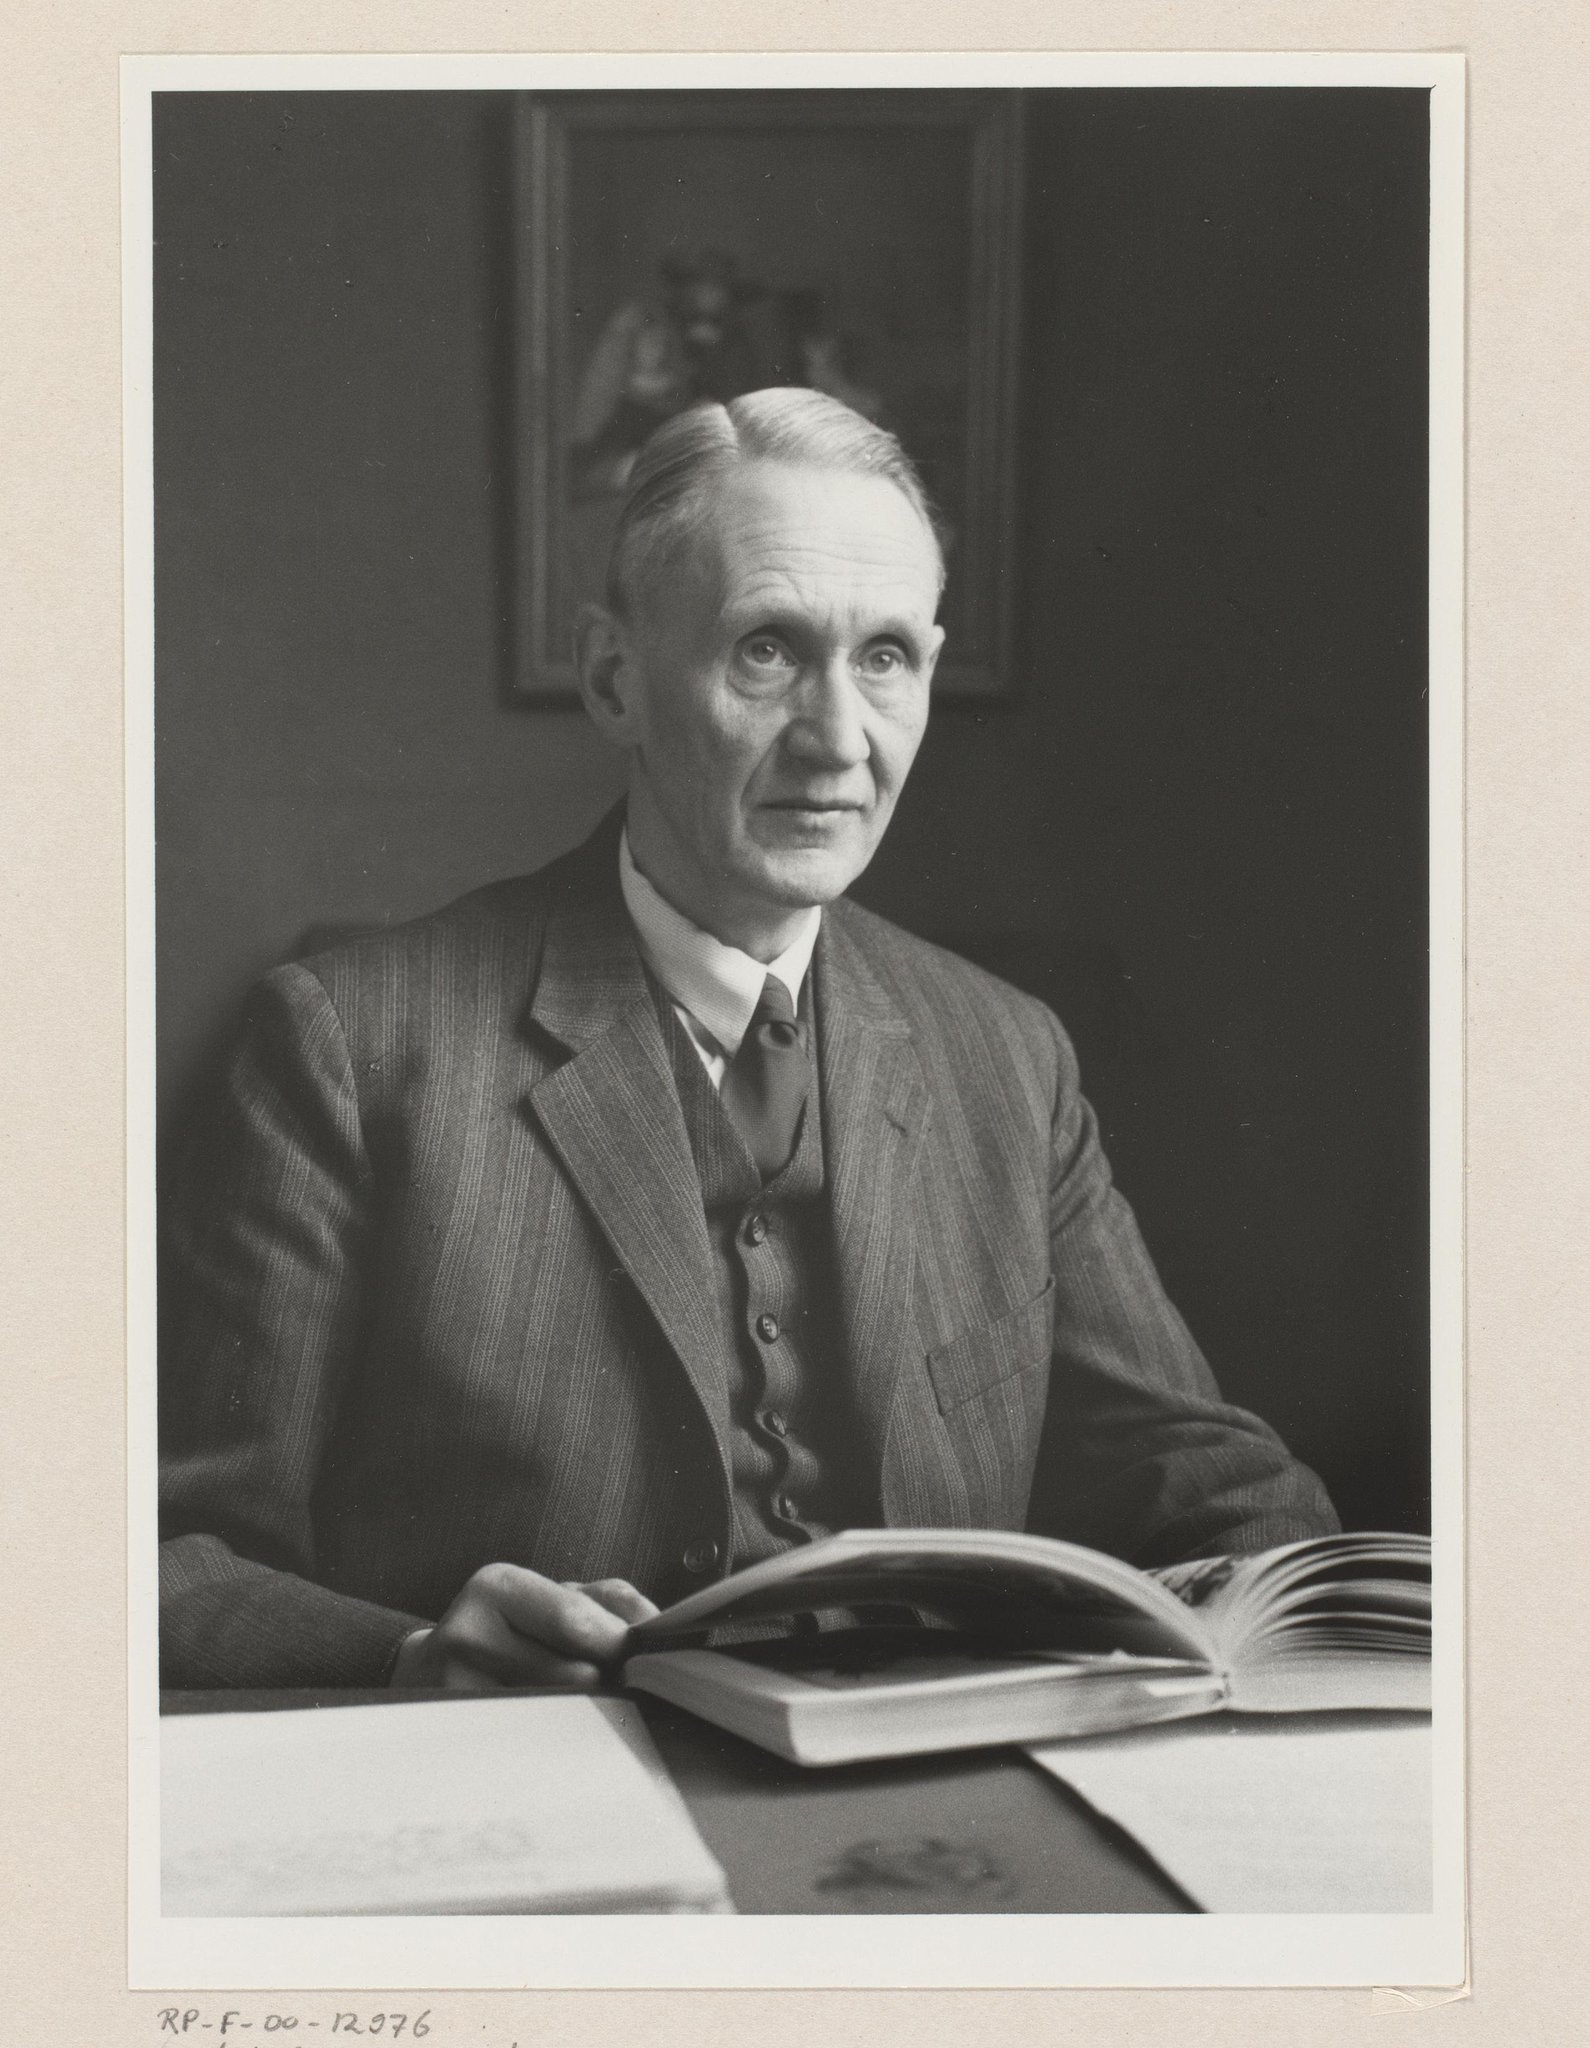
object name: photograph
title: Portret van Iohan Quirijn van Regteren Altena, directeur van het Rijksprentenkabinet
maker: Anonymous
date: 1960-1962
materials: paper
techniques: gelatin silver print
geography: amsterdam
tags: amsterdam, painter, iohan quirijn van regteren altena, historical persons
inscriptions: copyright notice: ‘Copyright/ Foto-Commissie/ Rijksmuseum/ Amsterdam’, inscription: ‘F366-8’